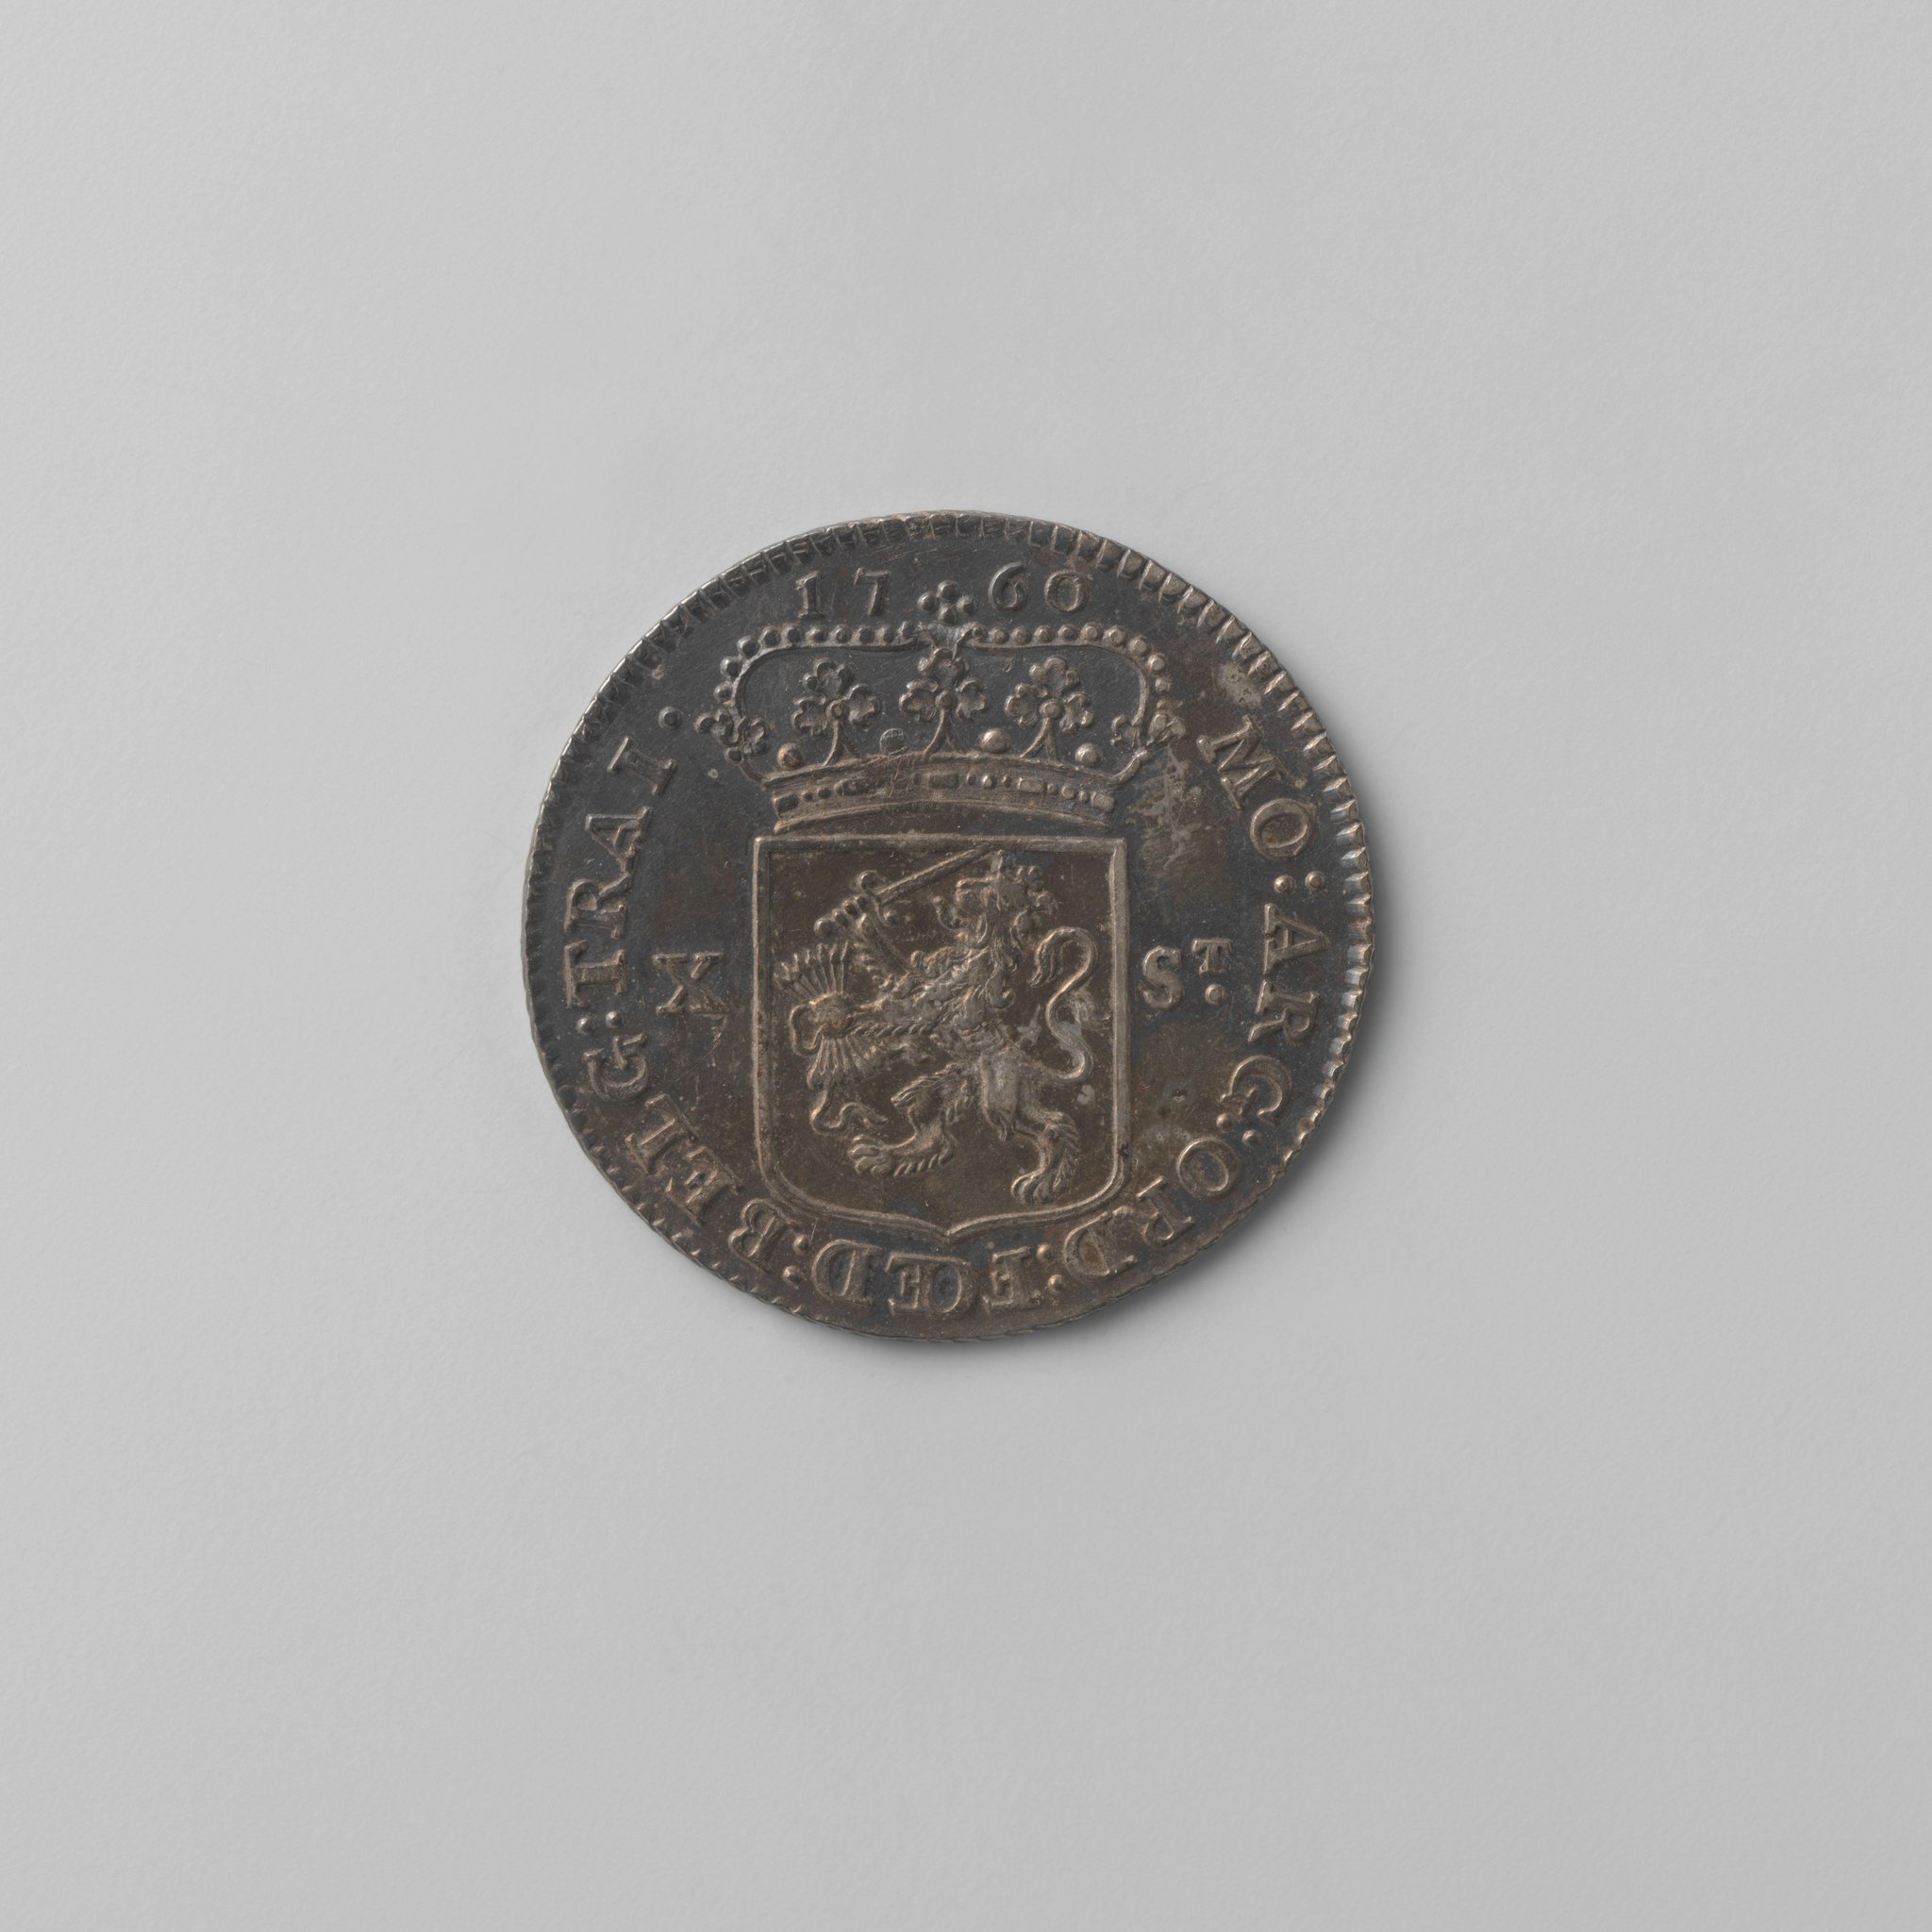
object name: halve gulden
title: Utrecht, halve gulden, 1760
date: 1760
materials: silver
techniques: striking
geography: utrecht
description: Zilveren munt. Voorzijde: tussen waarde-aanduiding X St gekroond generaliteitswapenschild. Jaartal boven kroon. Keerzijde: Nederlandse maagd met vrijheidshoed en speer, leunend op een bijbel op een altaar. Kabelrand.